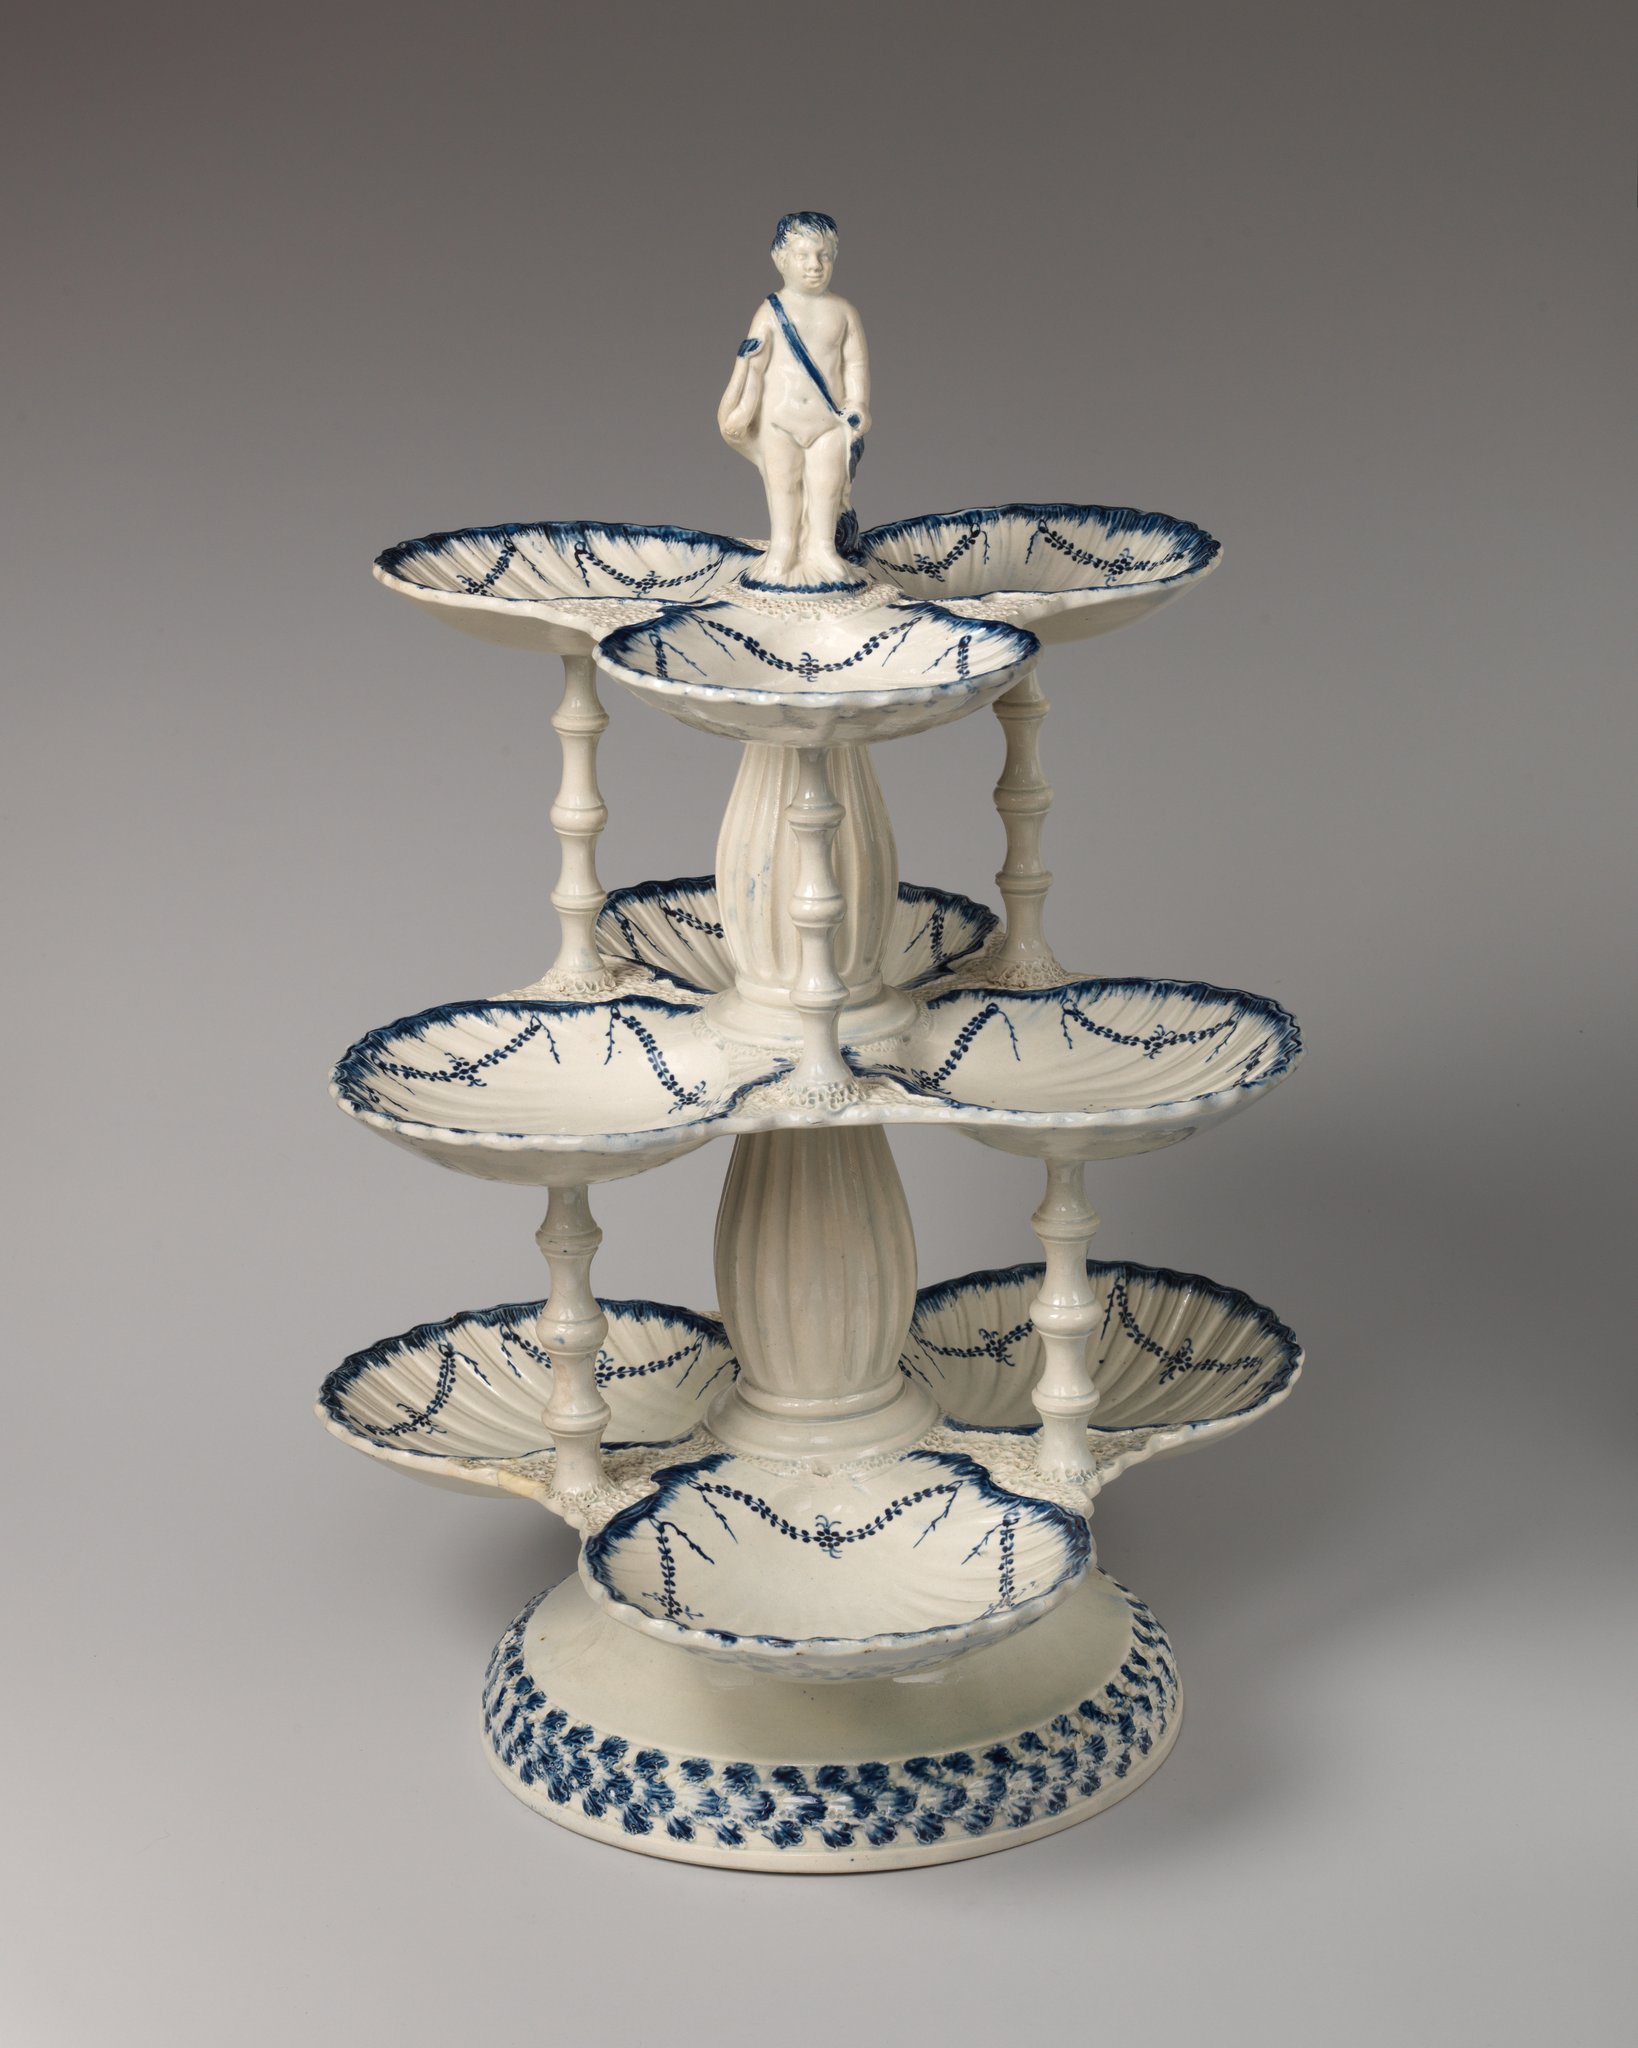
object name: centerpiece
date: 1815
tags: male nudes